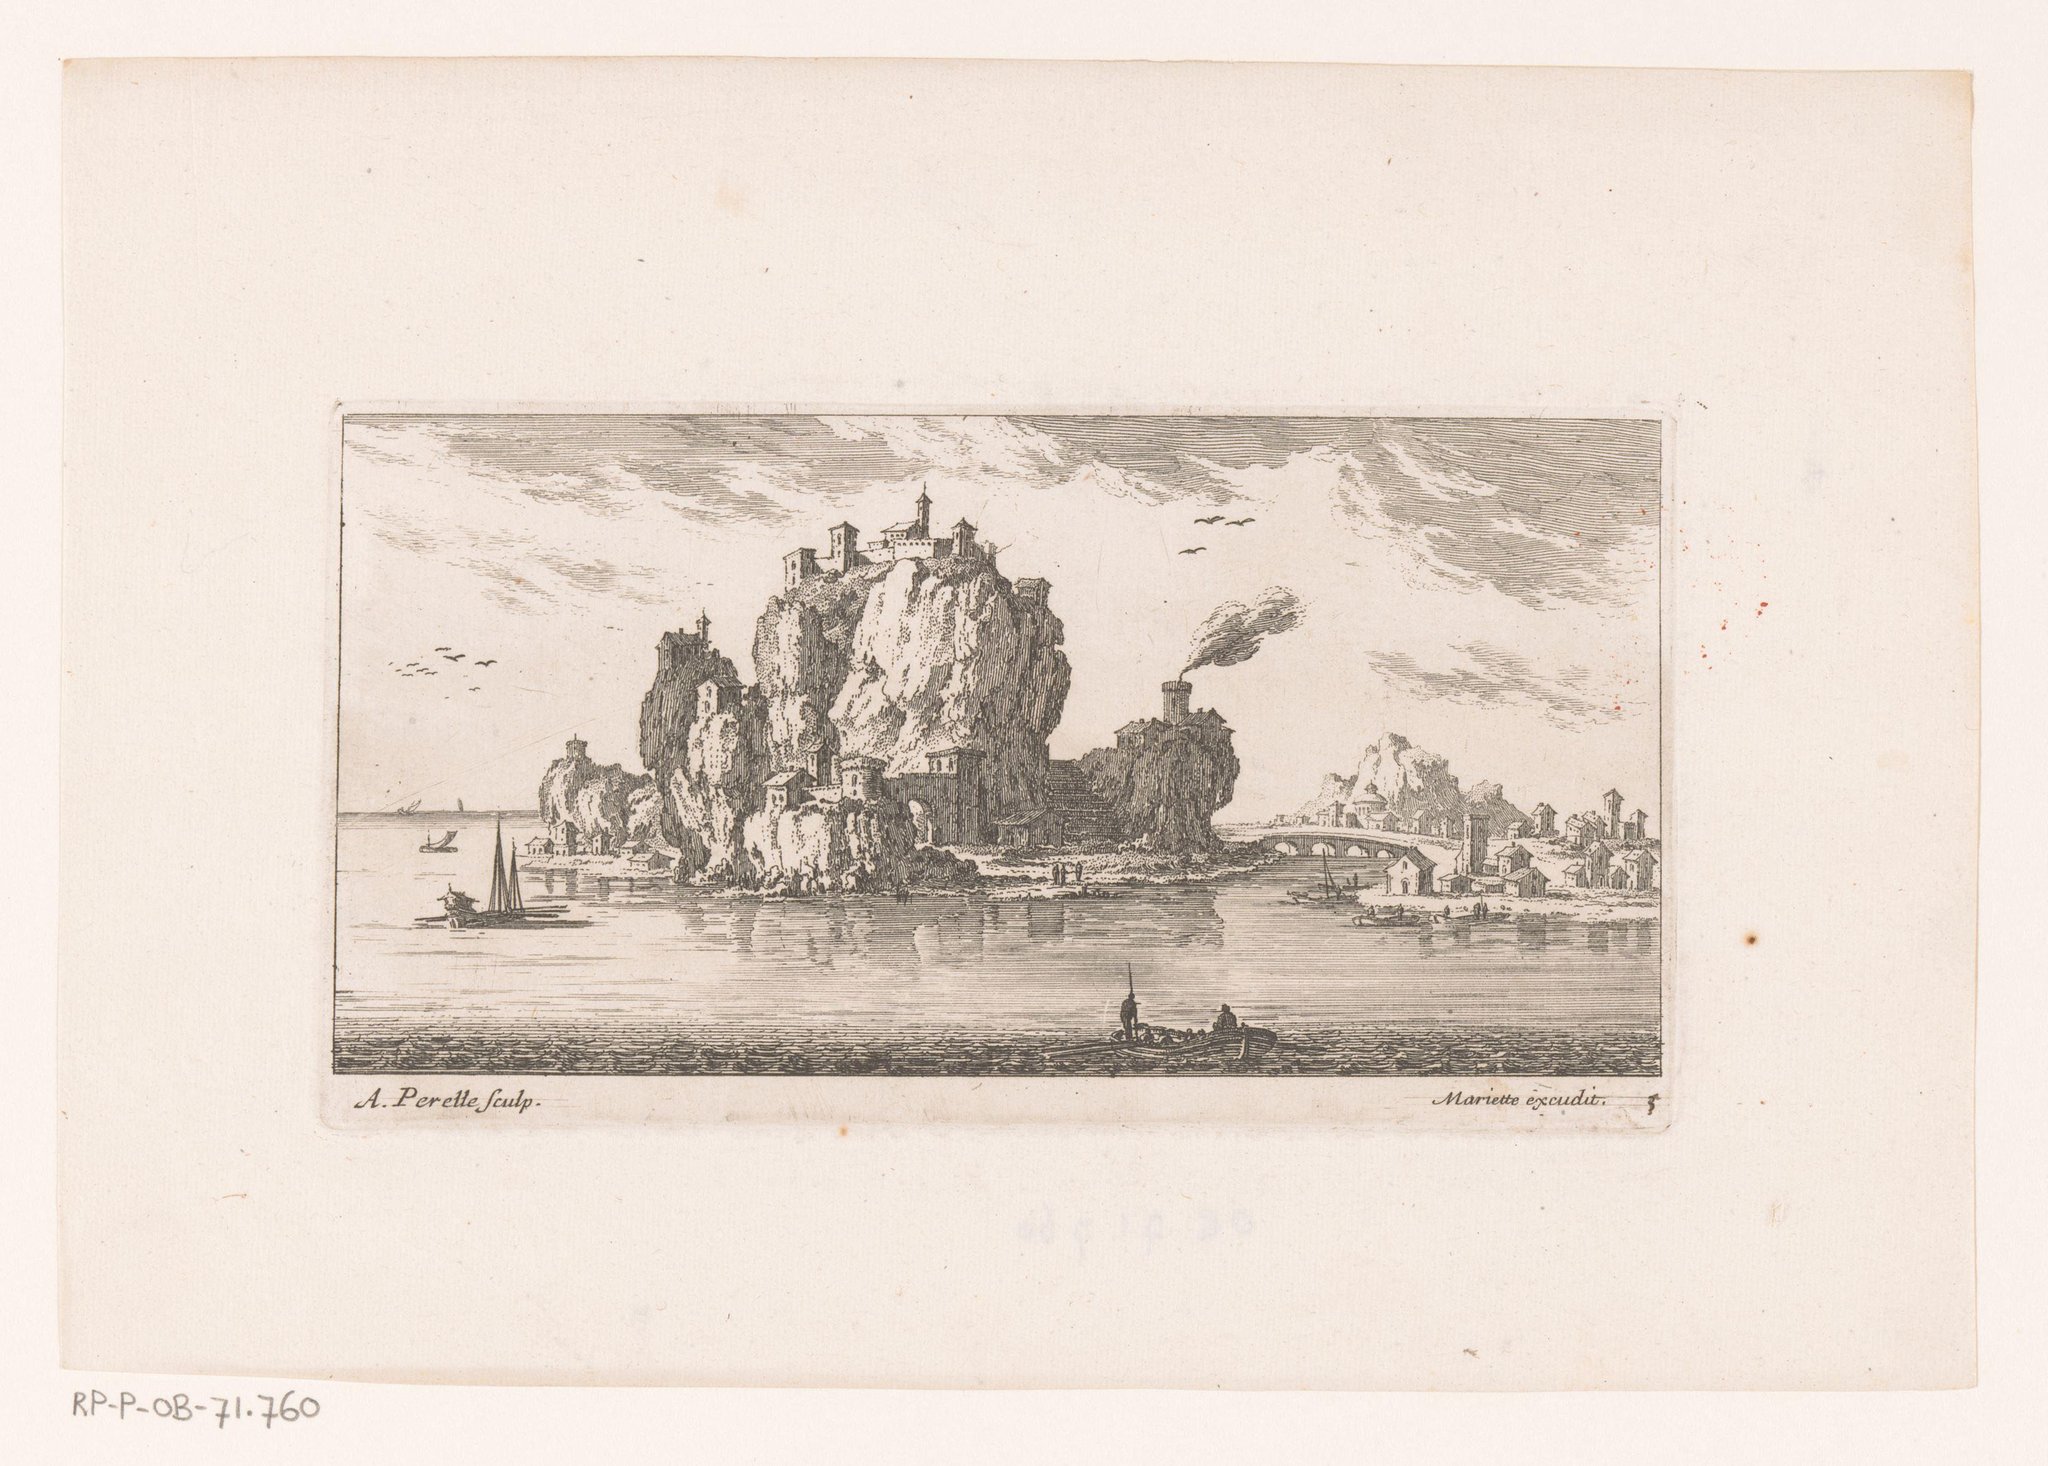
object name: print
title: Diverse landschappen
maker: adam perelle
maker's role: draughtsman, print maker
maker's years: 1638-1695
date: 1650-1695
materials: paper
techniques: etching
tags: prospect of village, silhouette of village, rock-formations, coast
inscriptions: collector's mark: Lugt 240